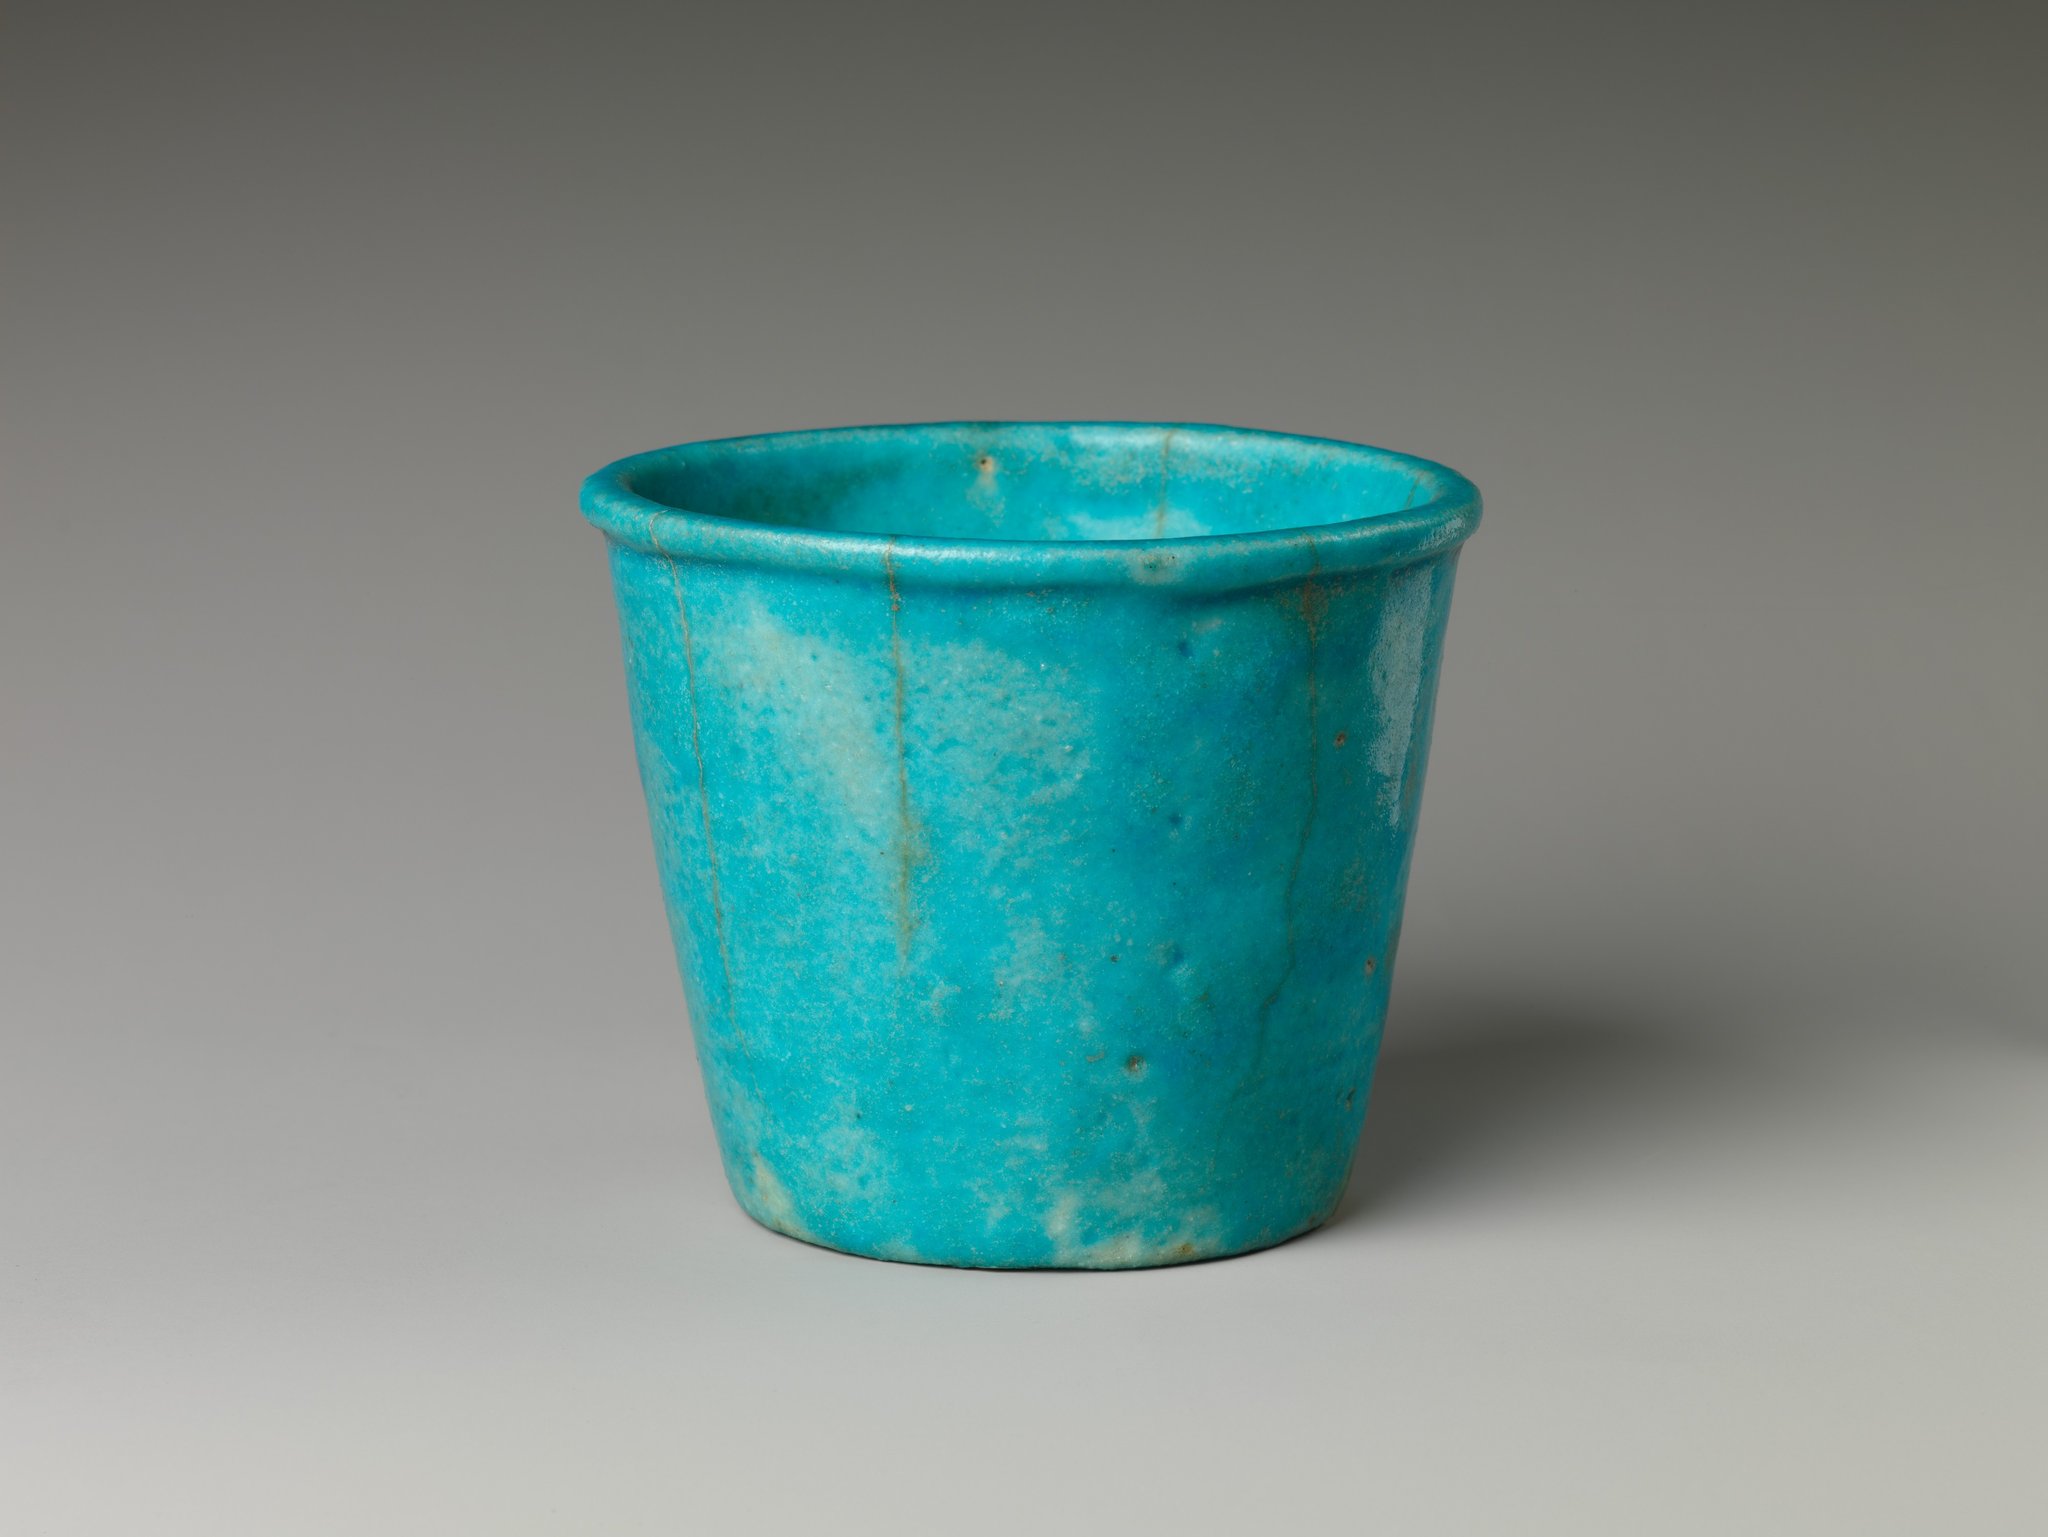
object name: cup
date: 500-200 BCE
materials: faience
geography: egypt